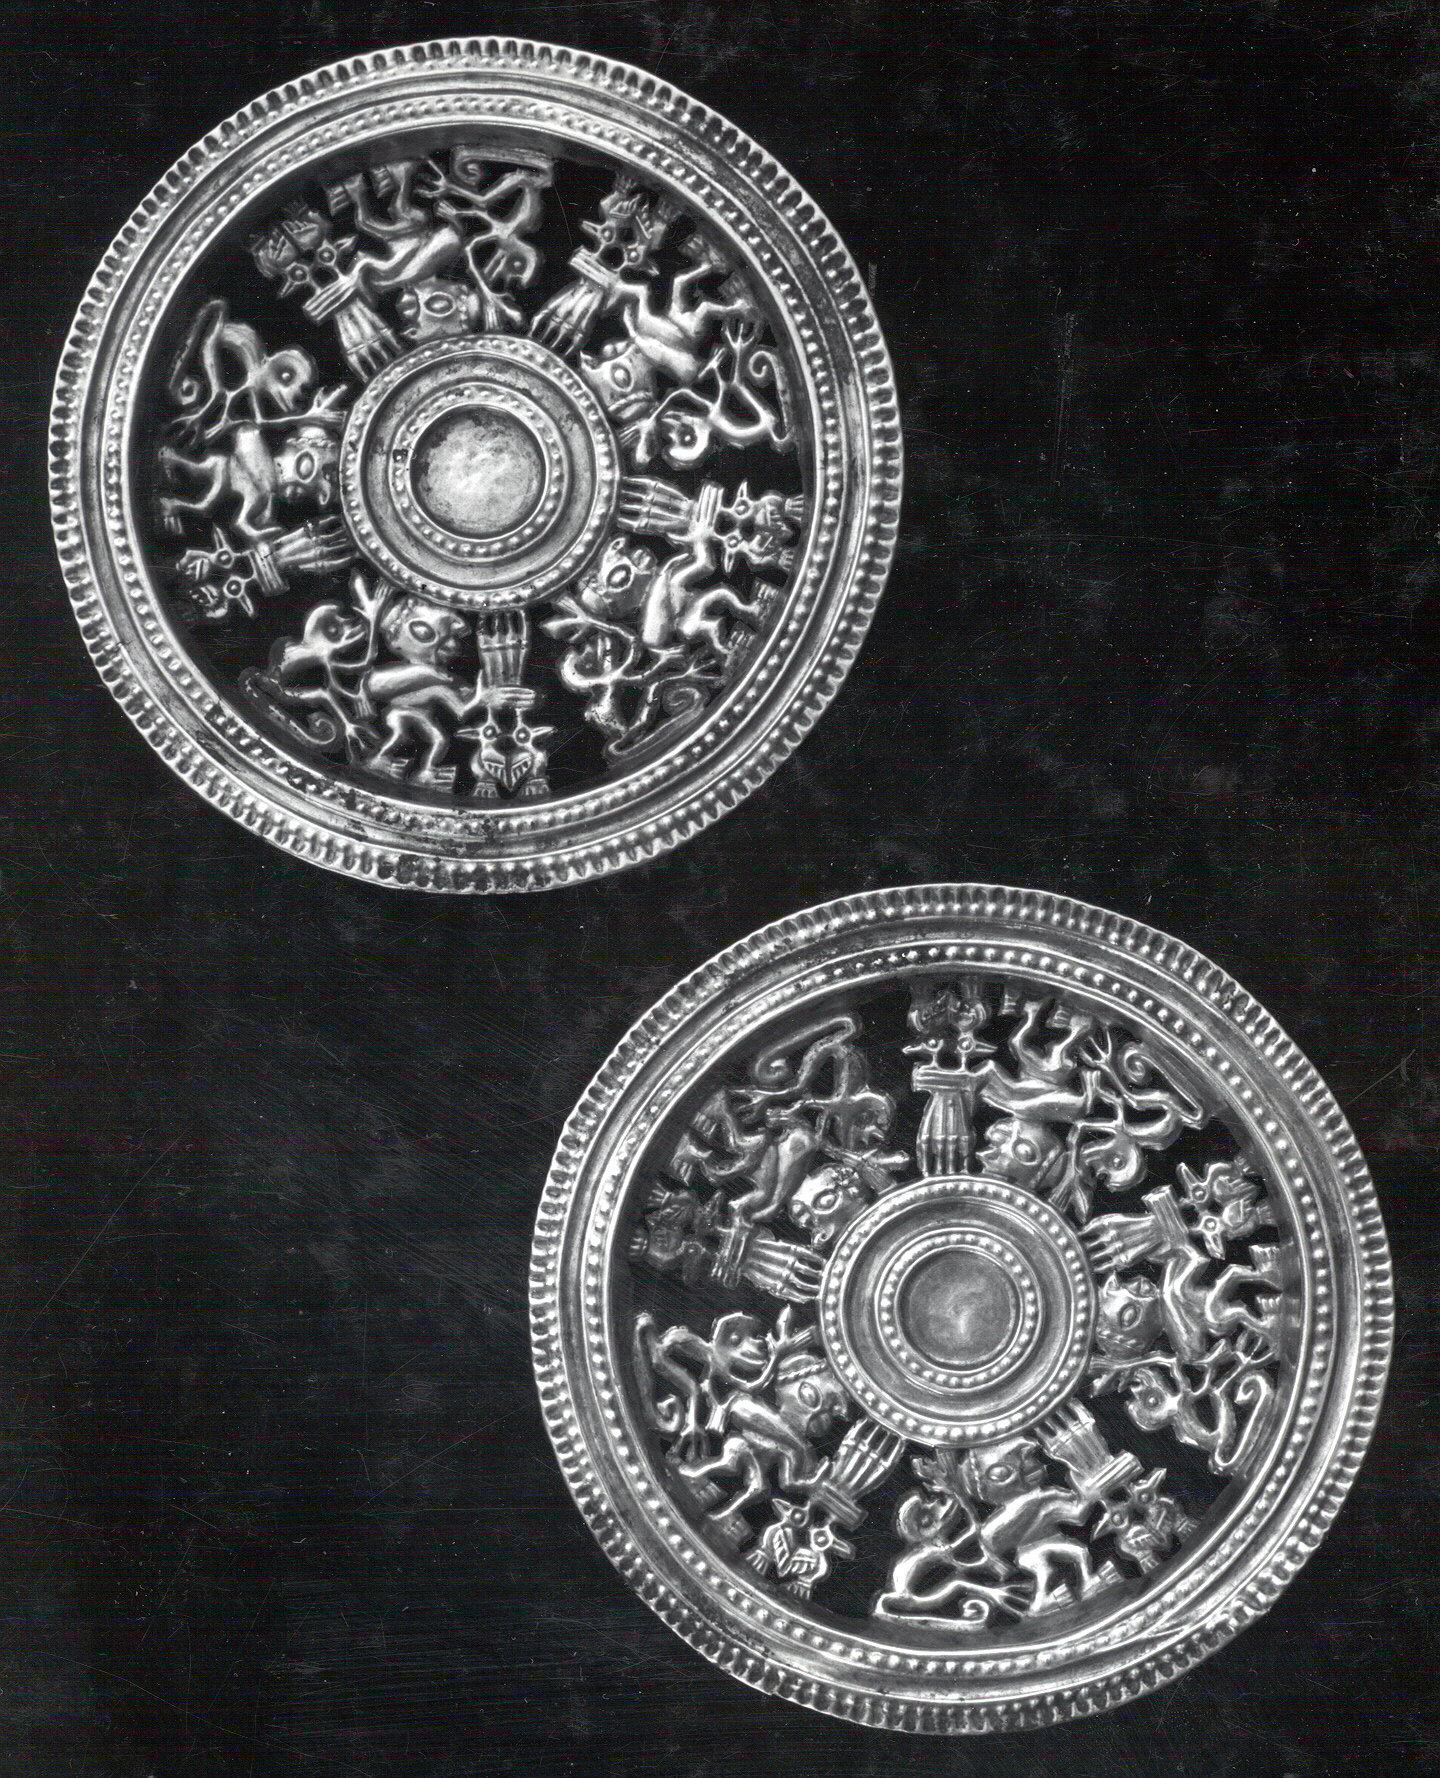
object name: earflare frontal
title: Pair of Earflare Frontals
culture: chimú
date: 1101-1500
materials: gold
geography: peru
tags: human figures,birds,monkeys